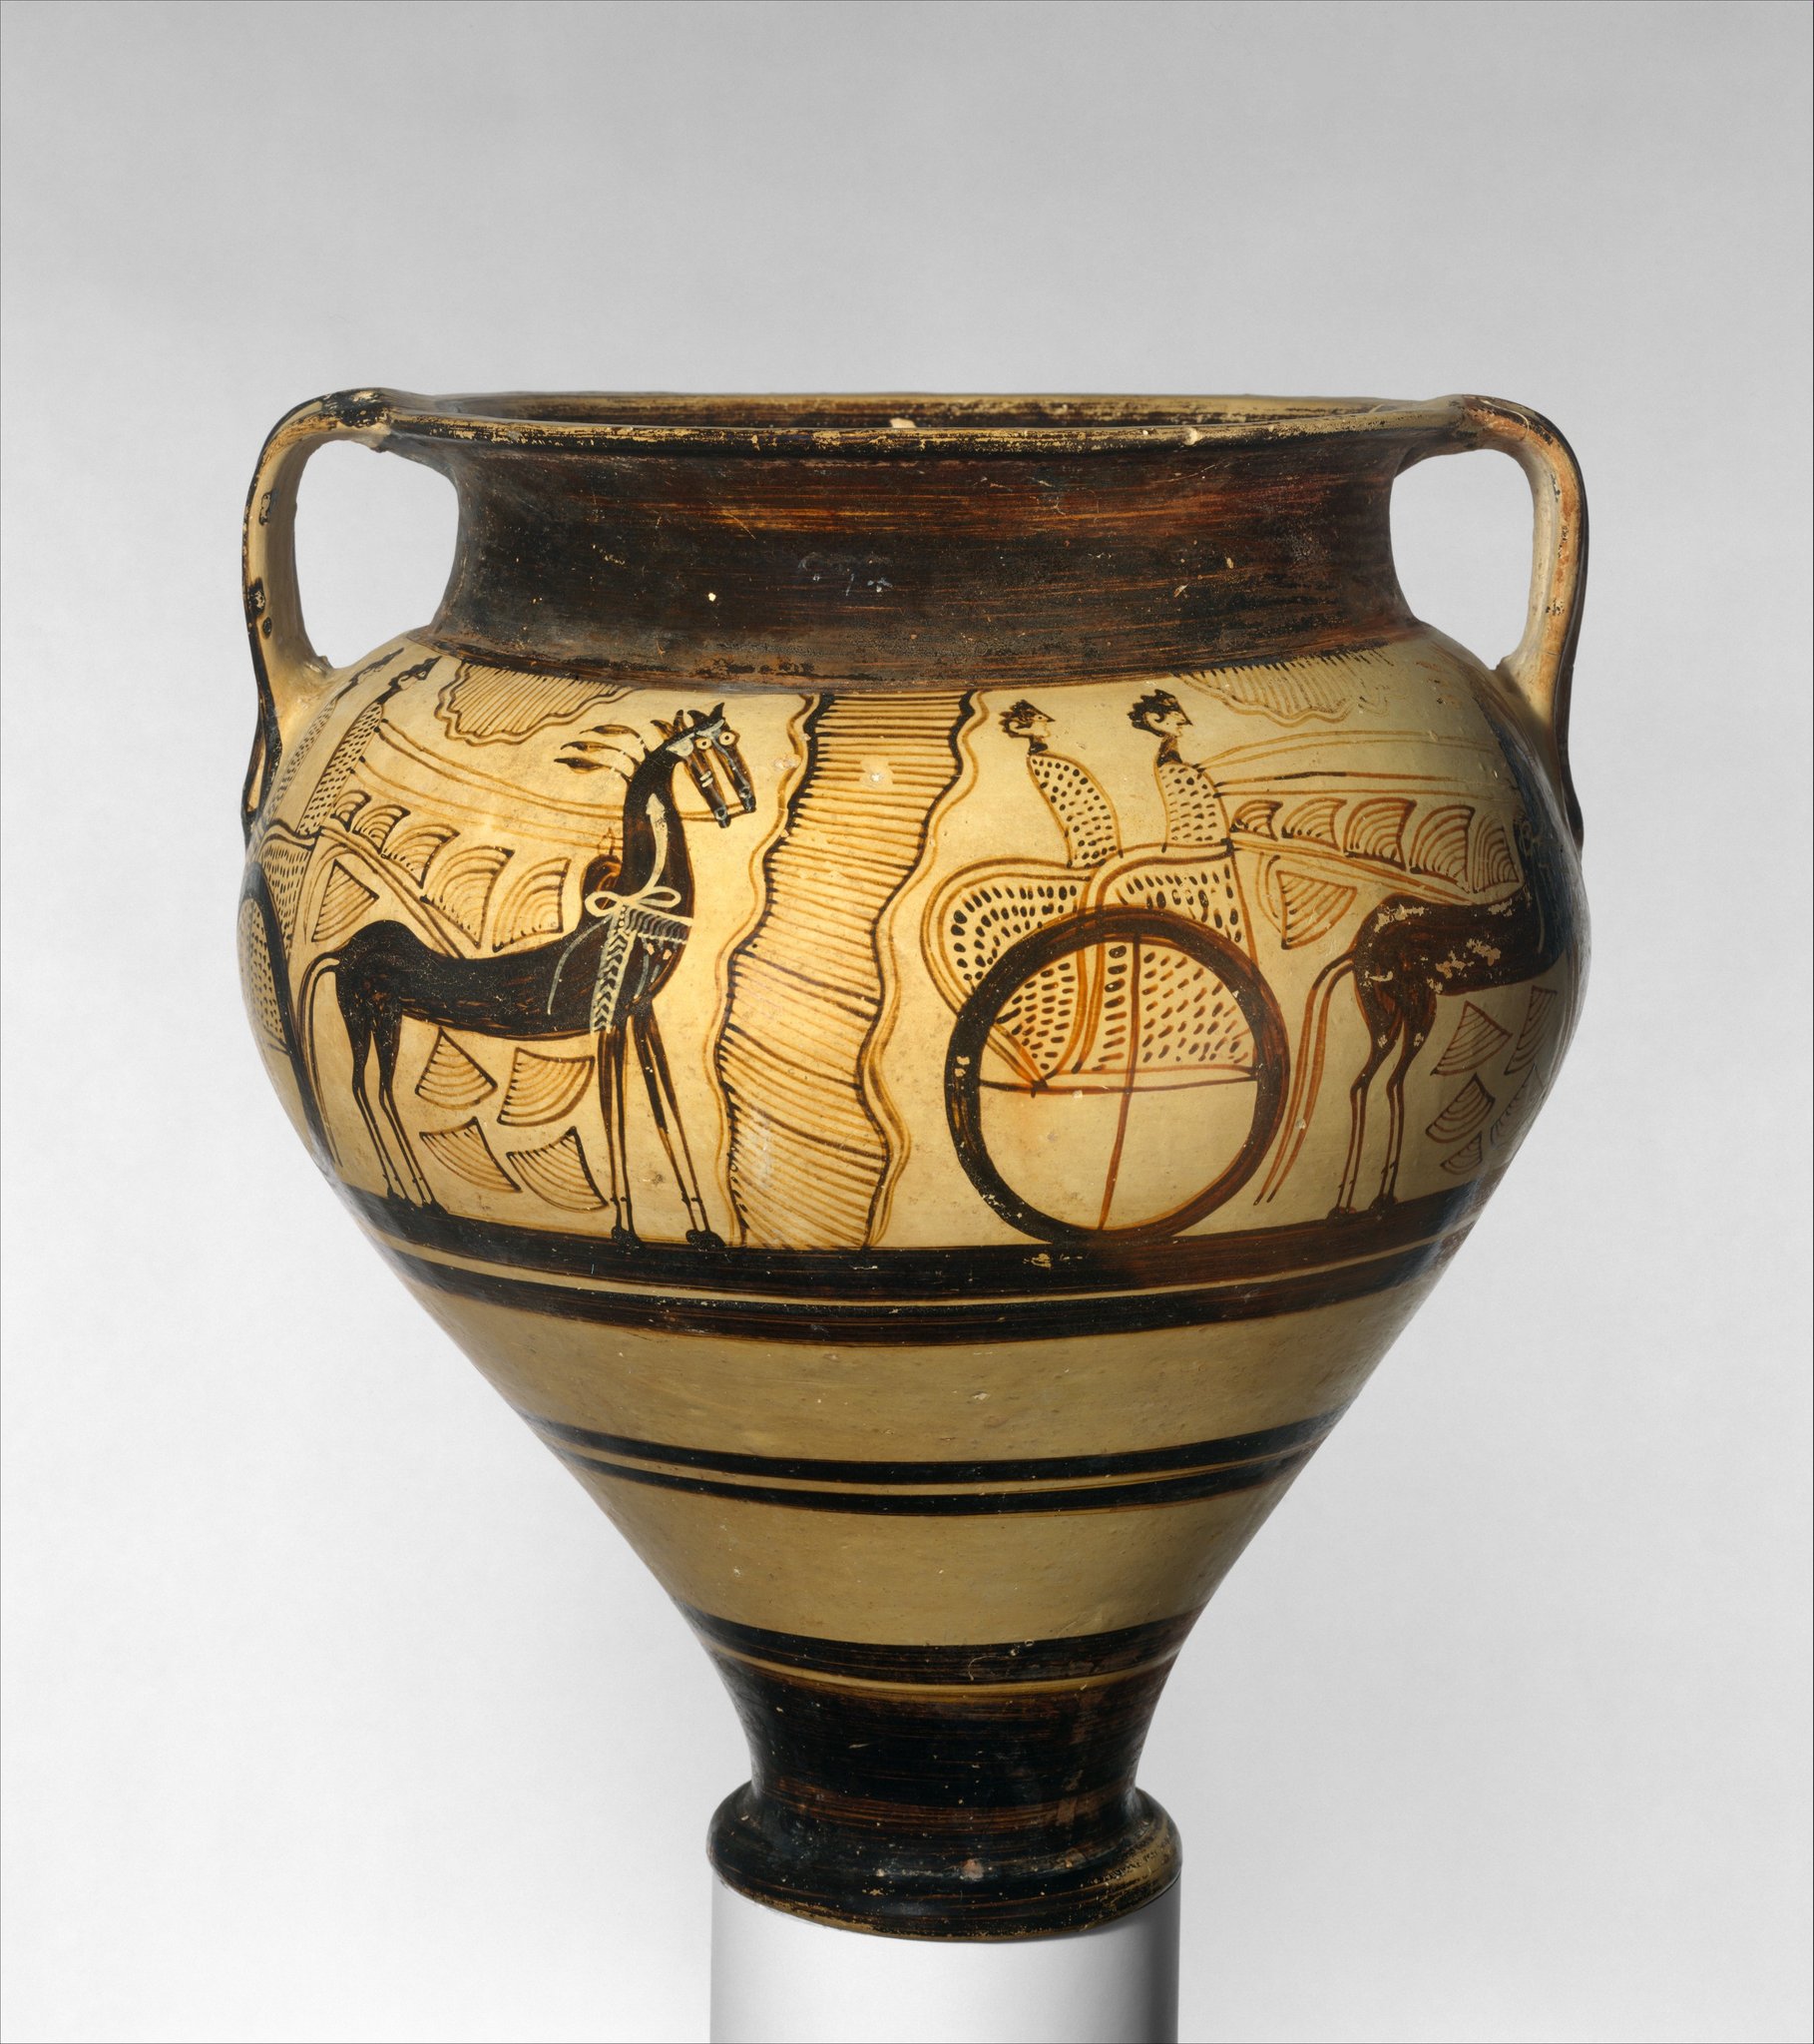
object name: krater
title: Terracotta chariot krater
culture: aegean, helladic or mycenaean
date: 1375-1350 BCE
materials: terracotta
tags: men,horses,chariots